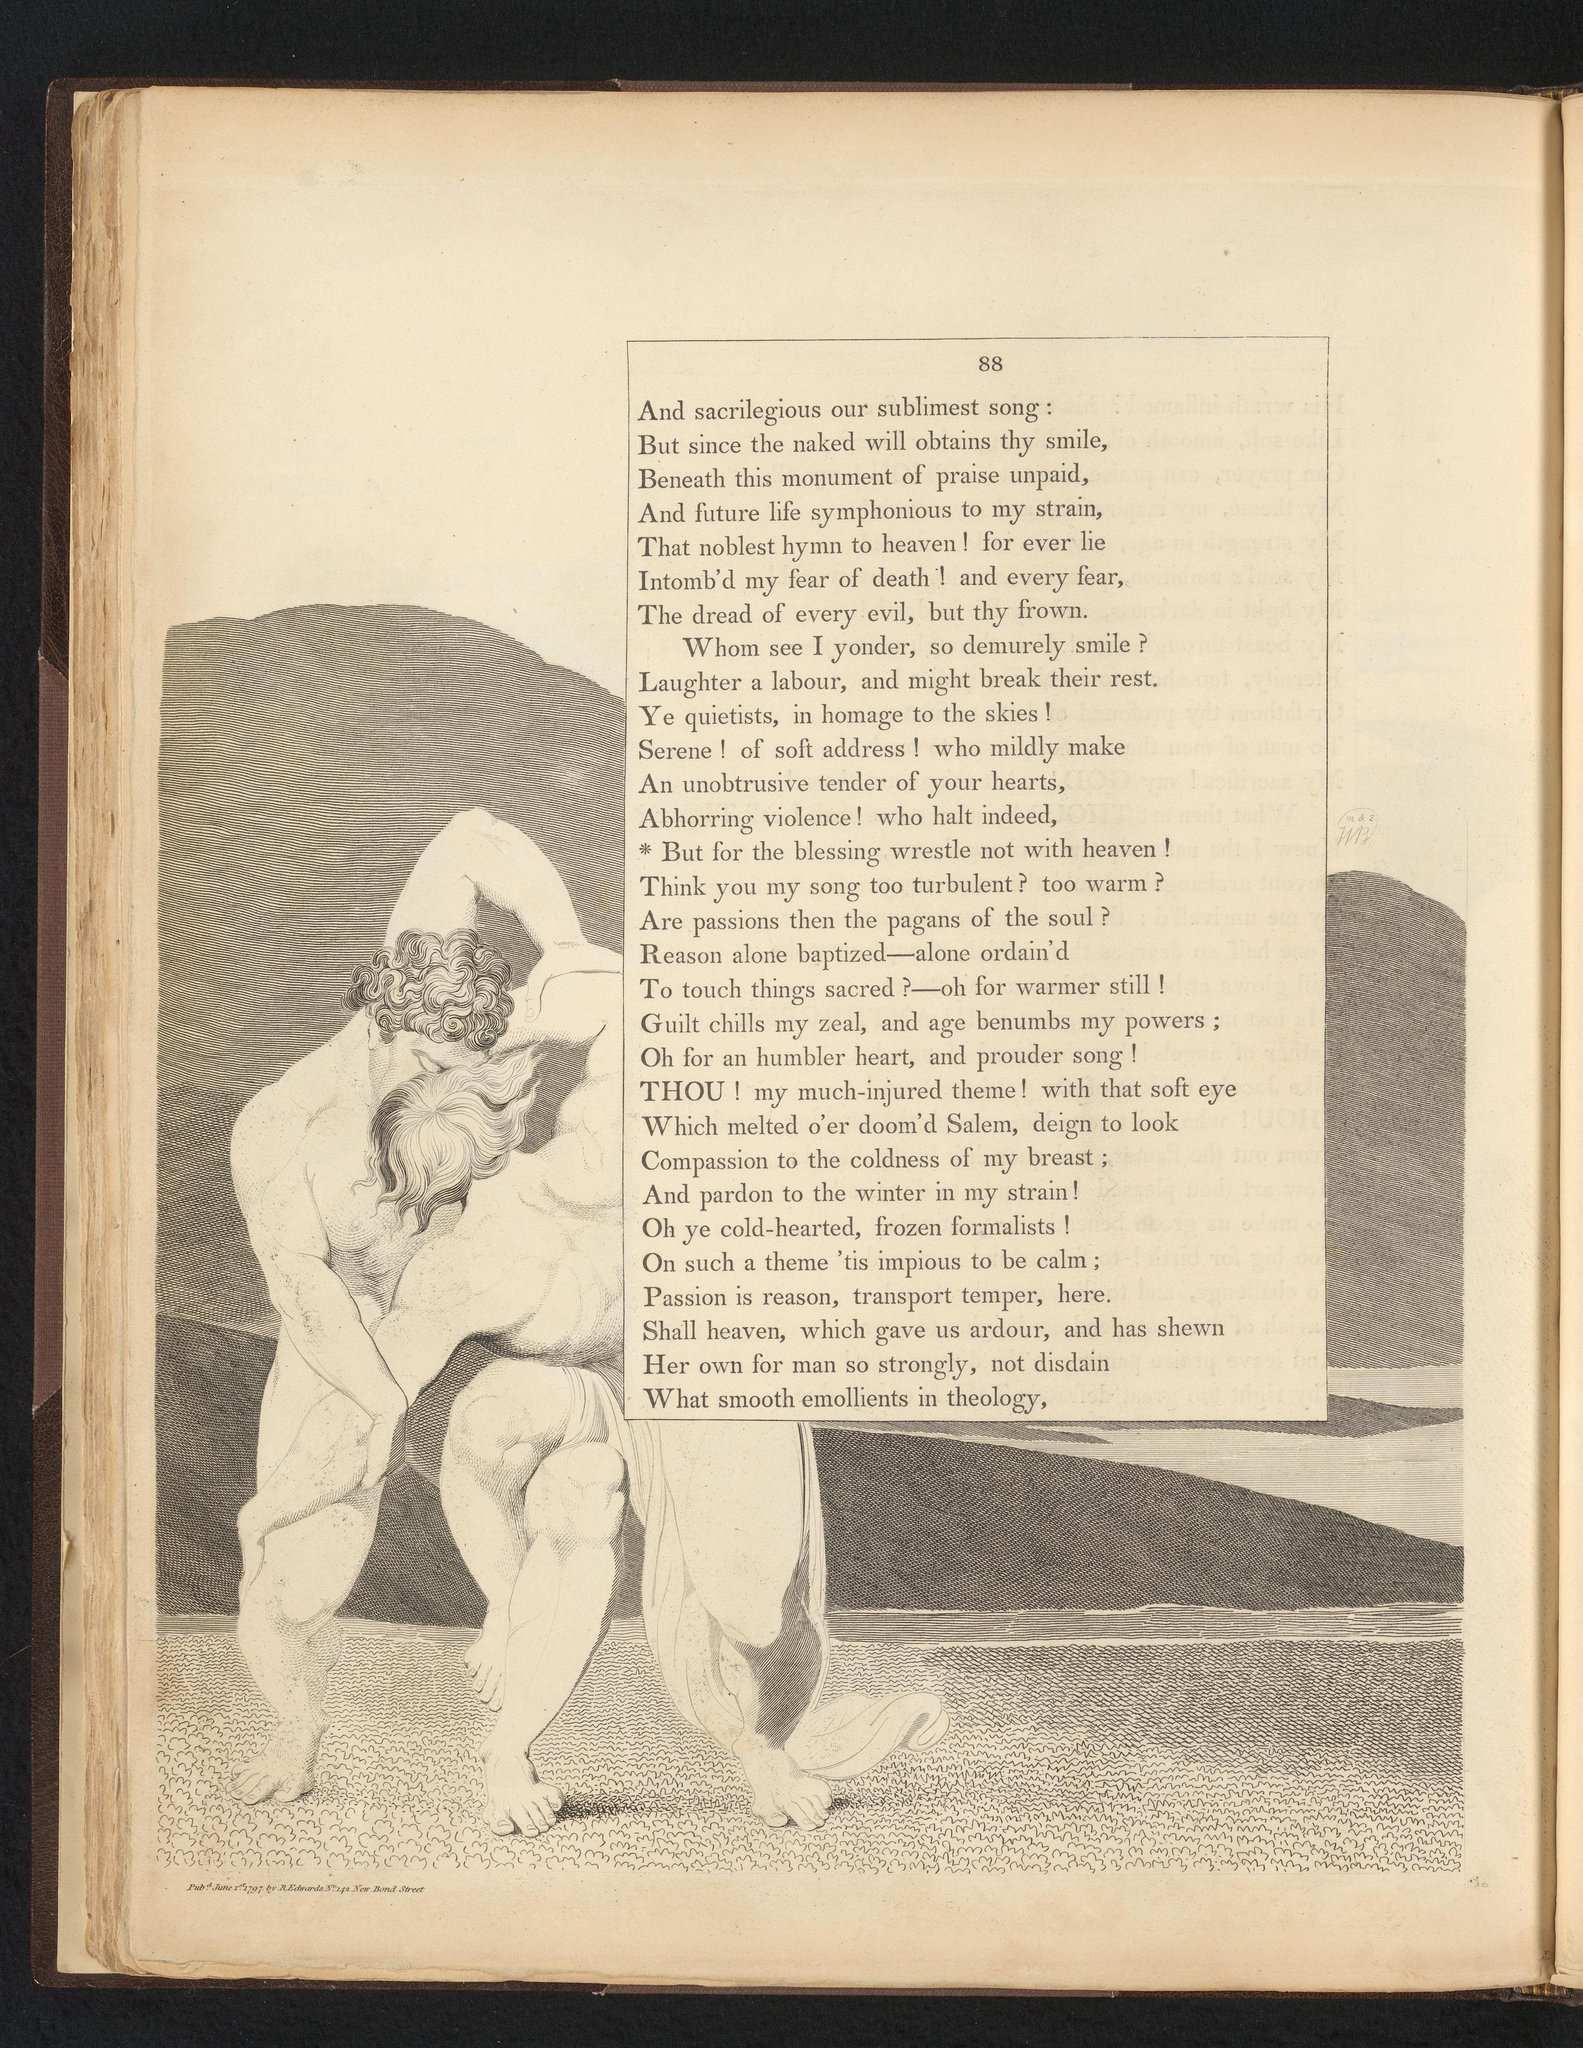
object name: print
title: Twee worstelende mannen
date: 1796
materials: paper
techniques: engraving, letterpress printing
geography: london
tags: adult man, wrestling (sport), fighting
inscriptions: : ‘And sacrilegious our sublimest song : (...)’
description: Prent maakt deel uit van een boek, bladzijde 88. Tekst in het Engels op het recto en verso.